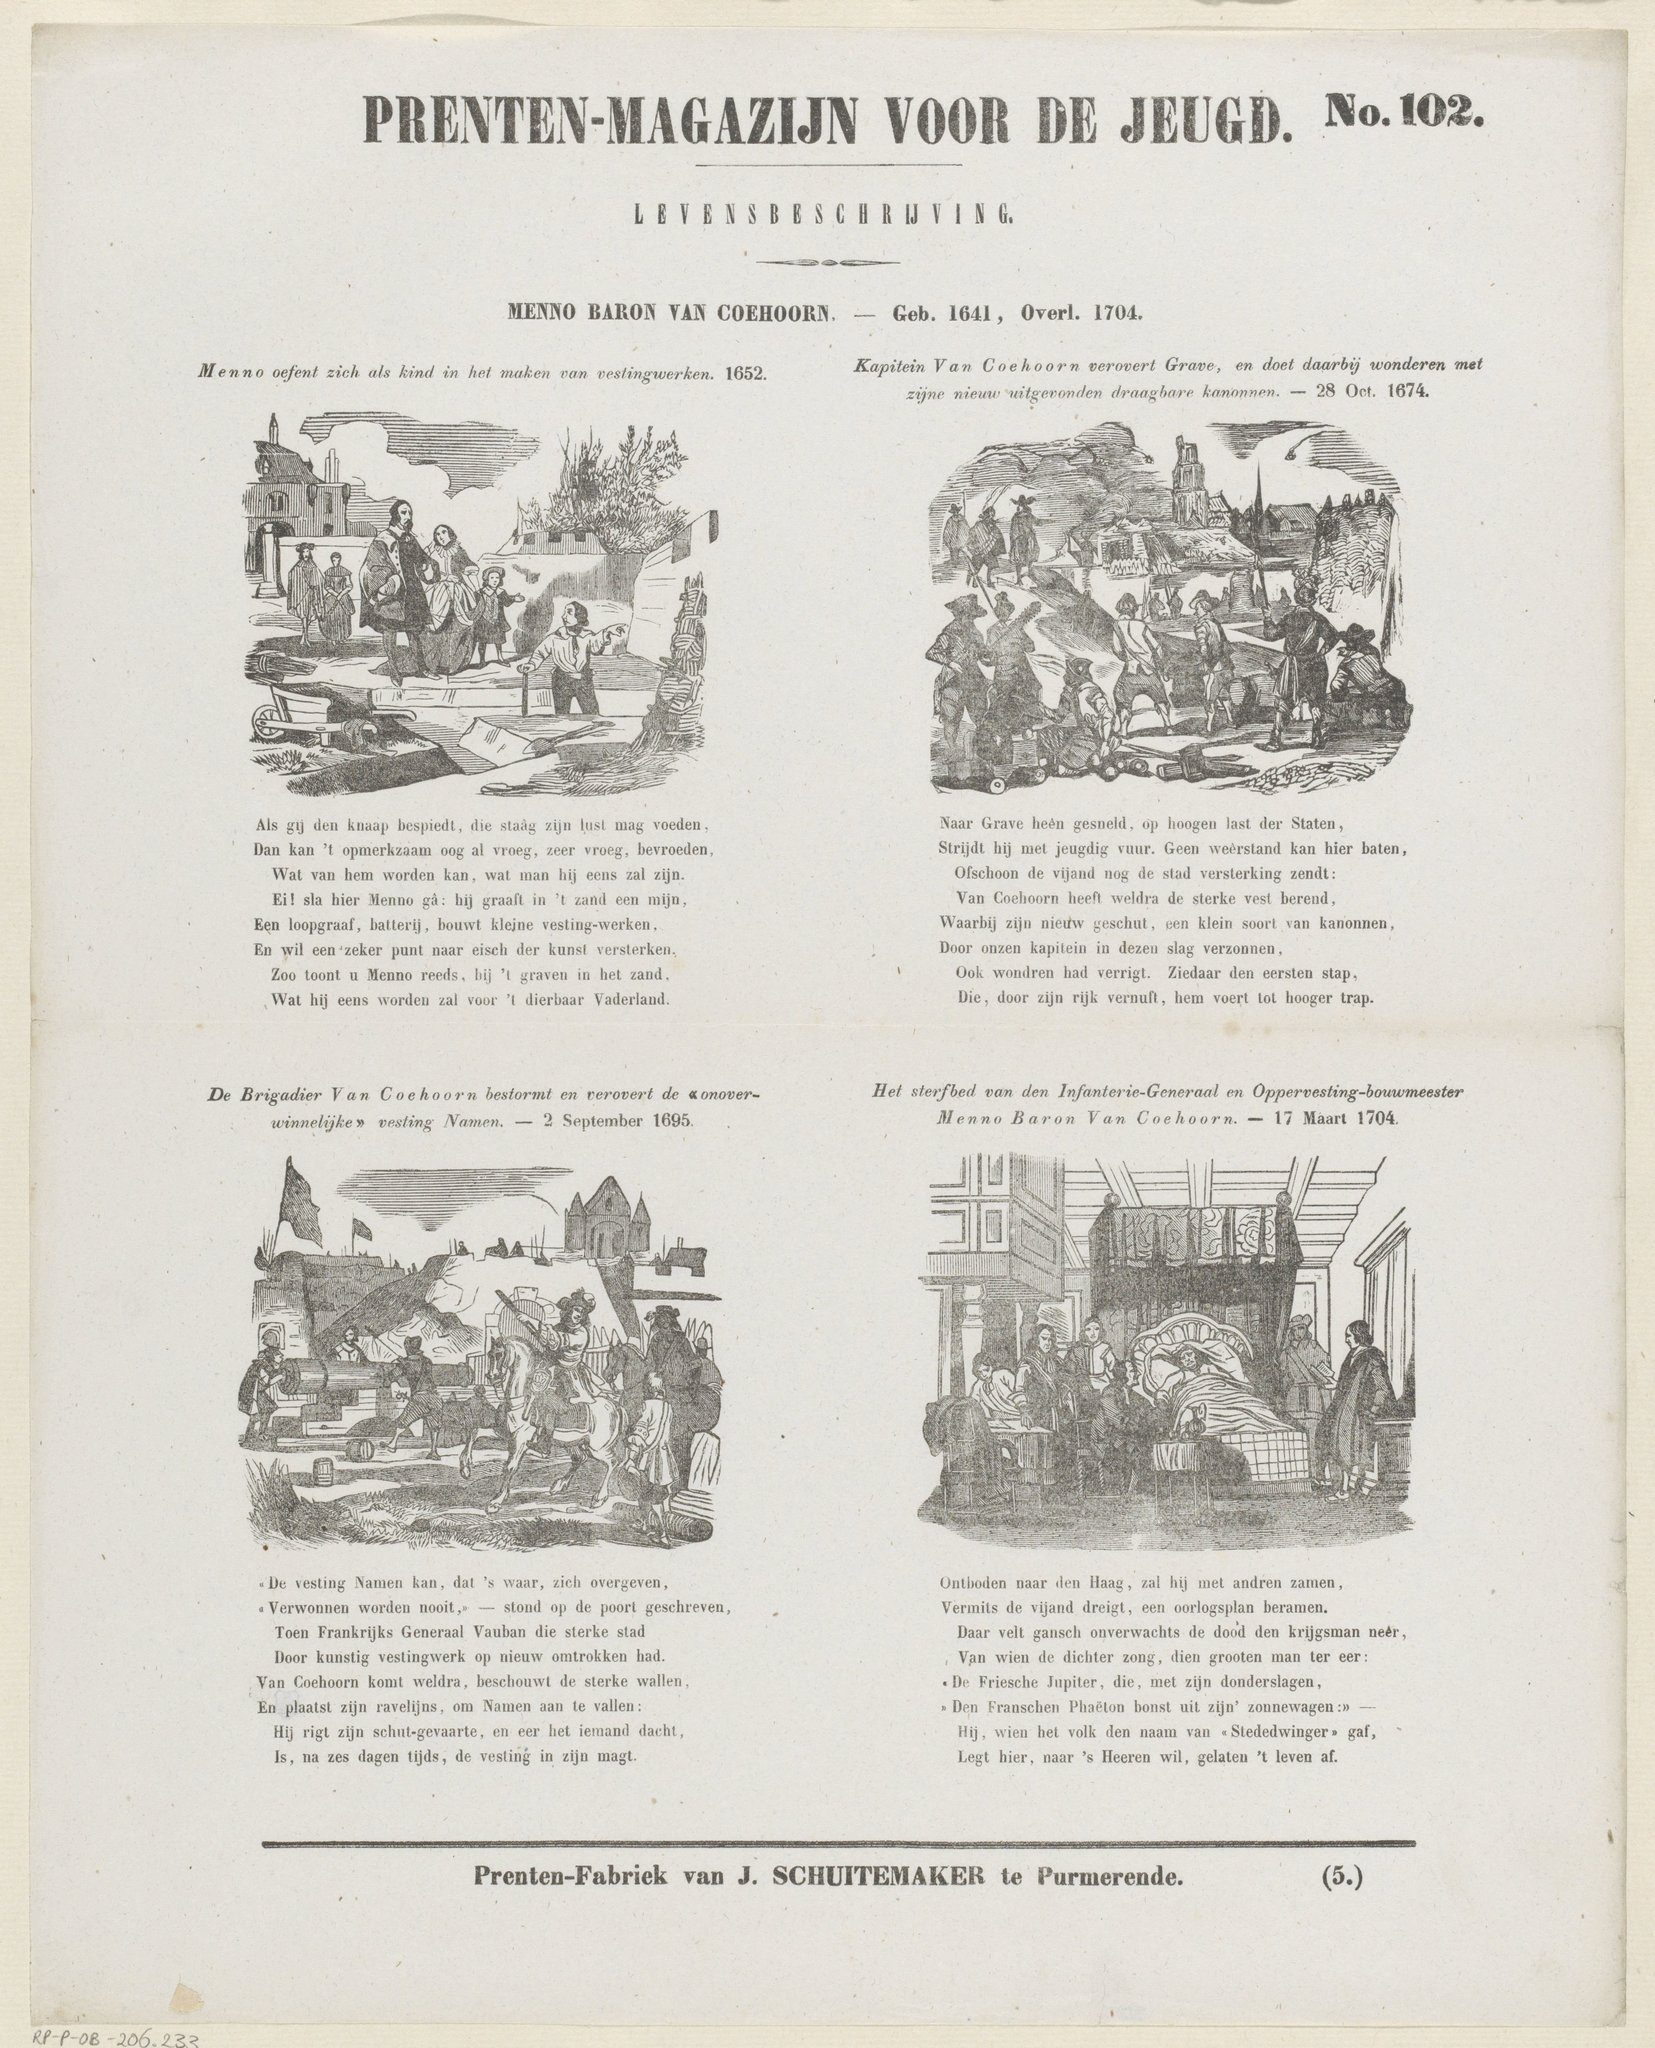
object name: popular print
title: Prenten-magazijn voor de jeugd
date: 1850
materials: paper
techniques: letterpress printing, engraving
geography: netherlands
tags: grave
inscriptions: collector's mark: Lugt 2760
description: Na voltooiing van de acht jaargangen van de reeks 'Prenten-magazijn voor de jeugd' in 1850 heeft Jan Schuitemaker al deze prenten heruitgegeven en omgenummerd als nr. 1 t/m 192. De oorspronkelijke jaargang wordt telkens nog vermeld rechtsonder op de prent. Binnen de jaargangen zijn prenten van hetzelfde thema in clusters van vier achter elkaar gezet.